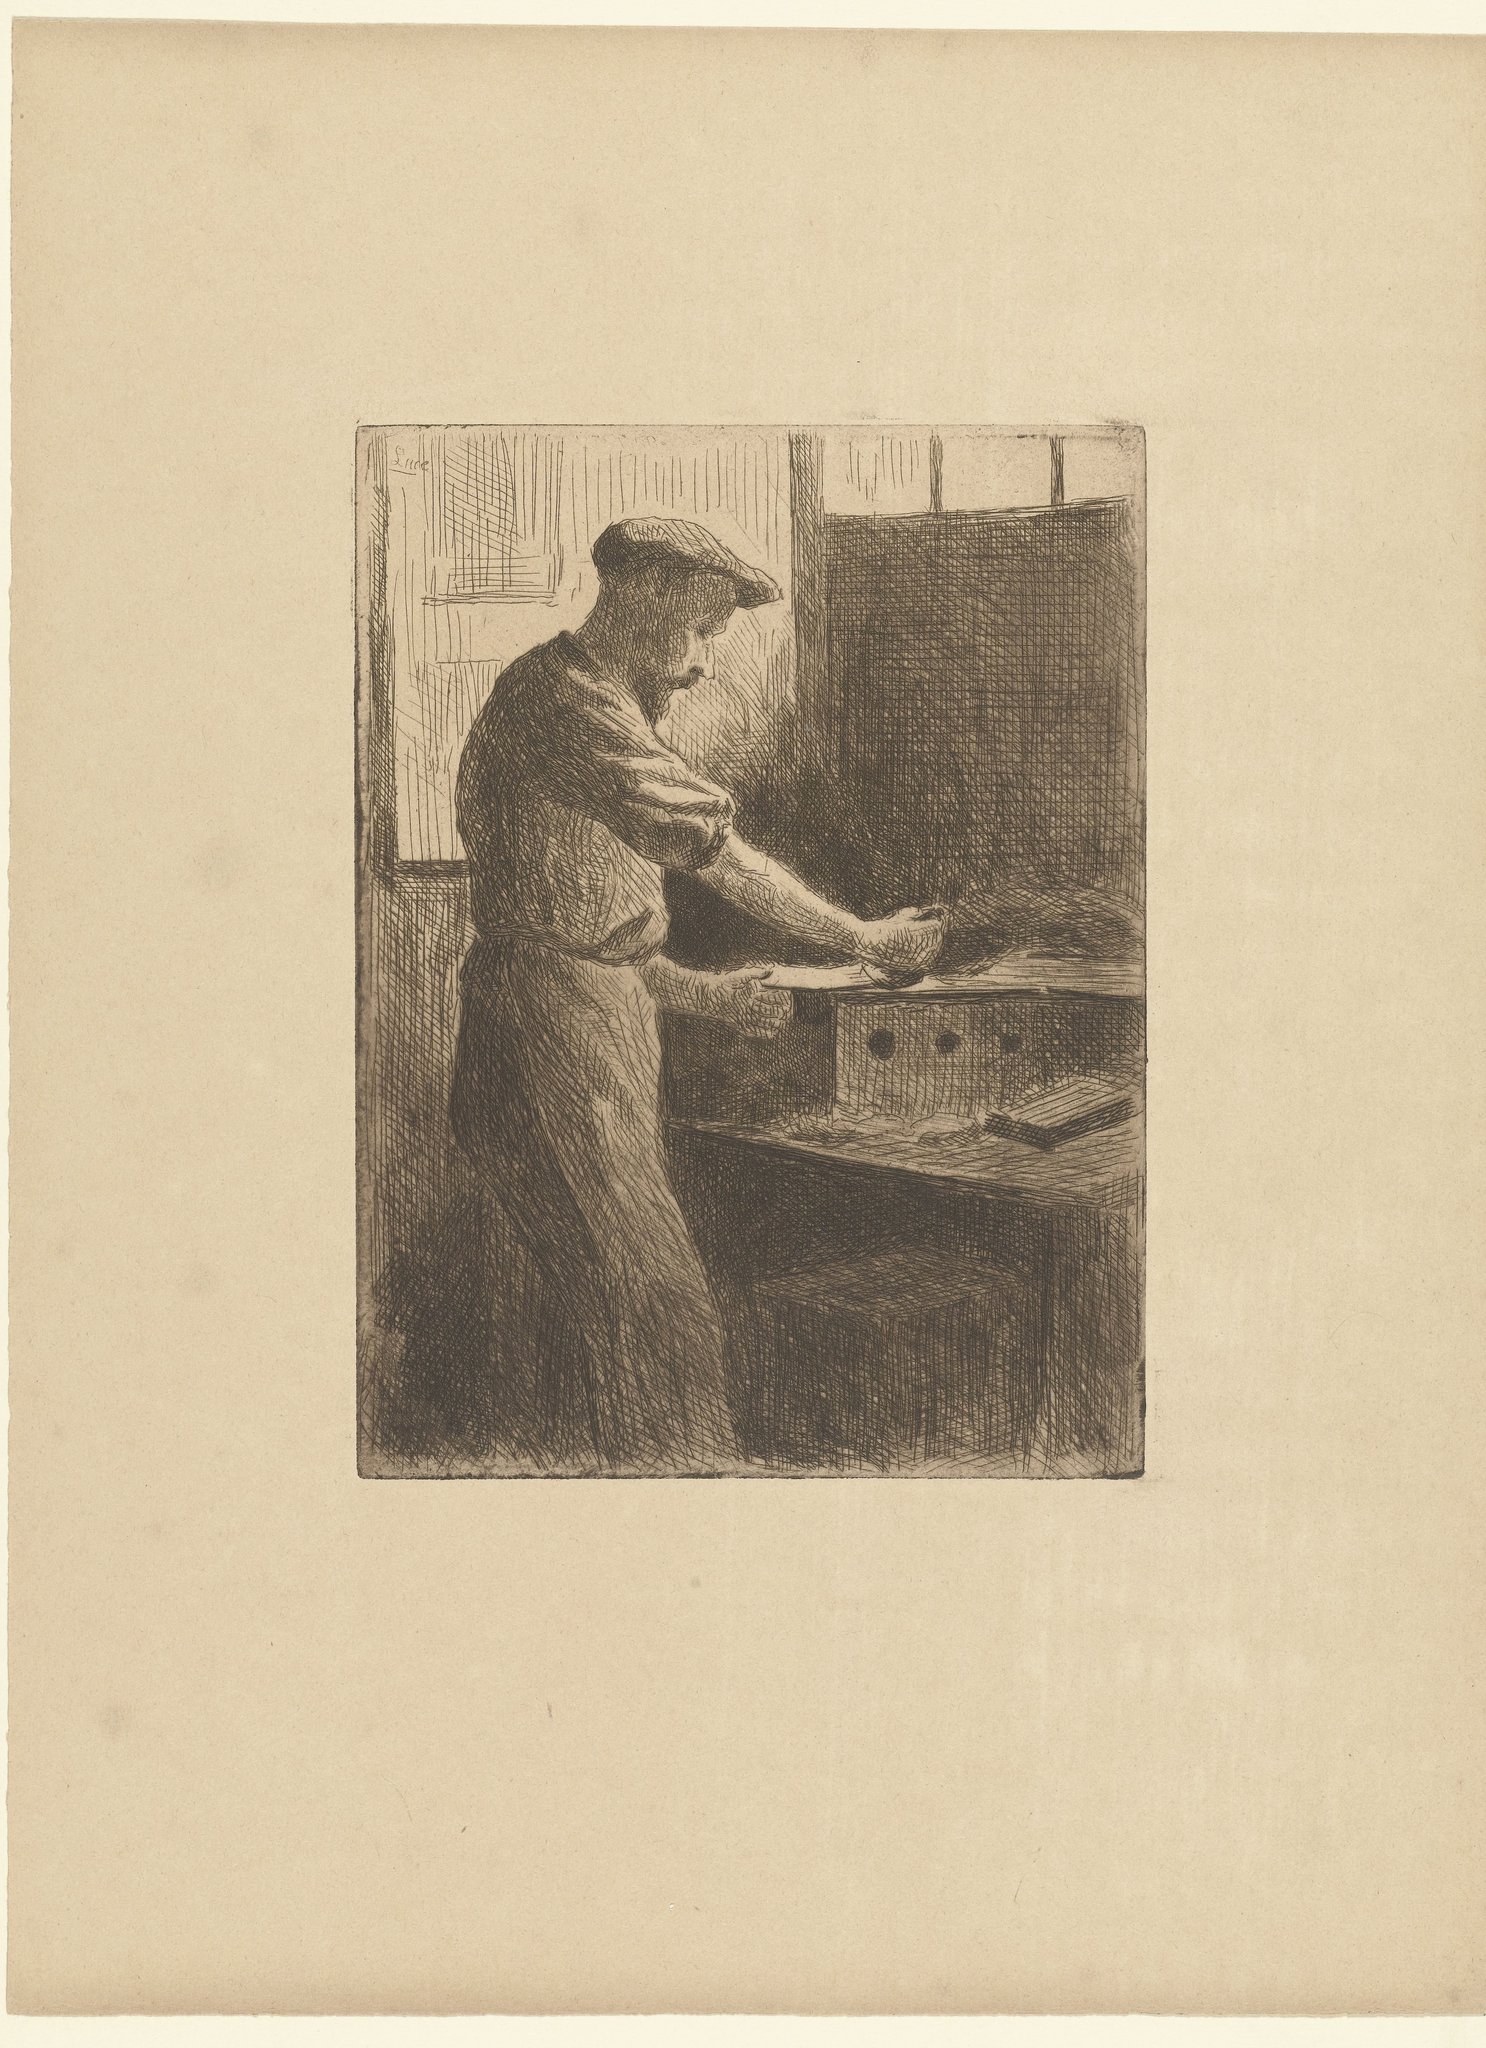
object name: print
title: L'Epreuve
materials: paper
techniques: etching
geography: paris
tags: printer, tools, implements of printer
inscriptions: collector's mark: Lugt 2228, collector's mark: Lugt 2760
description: Verschenen in album met tien originele prenten als supplement bij tijdschrift: L'Epreuve, maart 1895, prent nr. 8